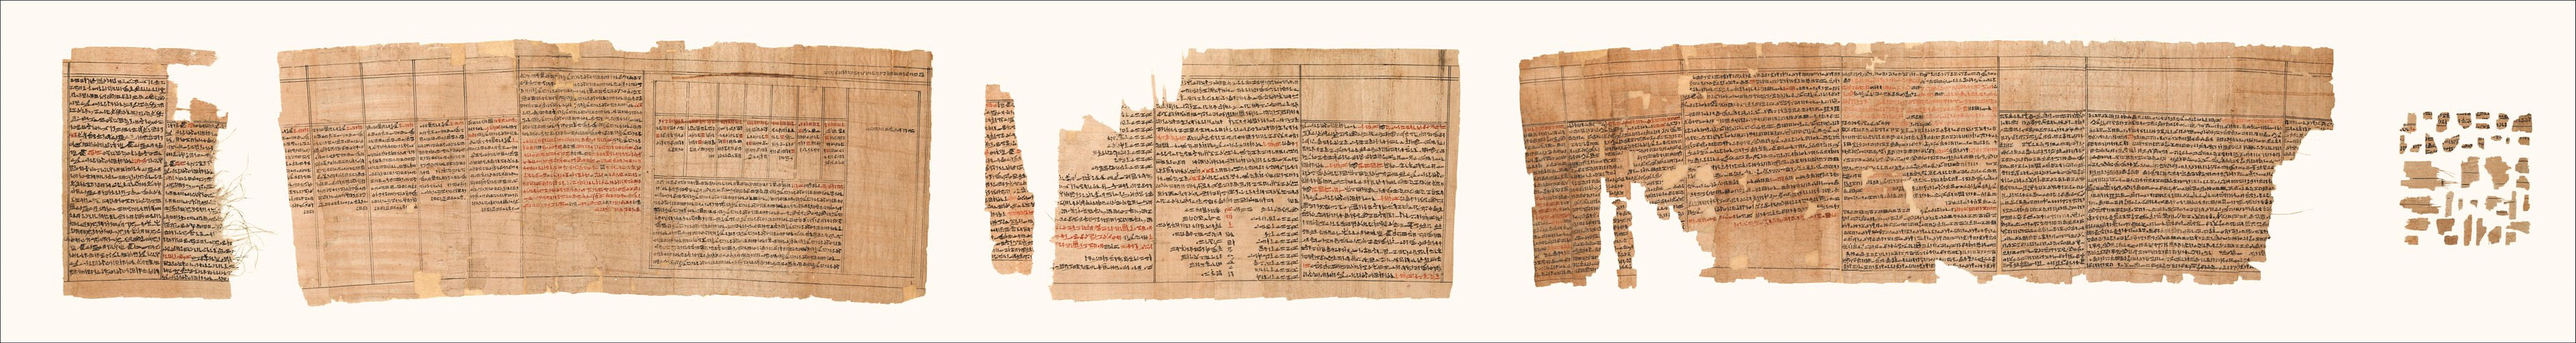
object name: papyrus, funerary, book of the dead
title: Book of the Dead of Khamhor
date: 630 BCE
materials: ink, papyrus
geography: egypt